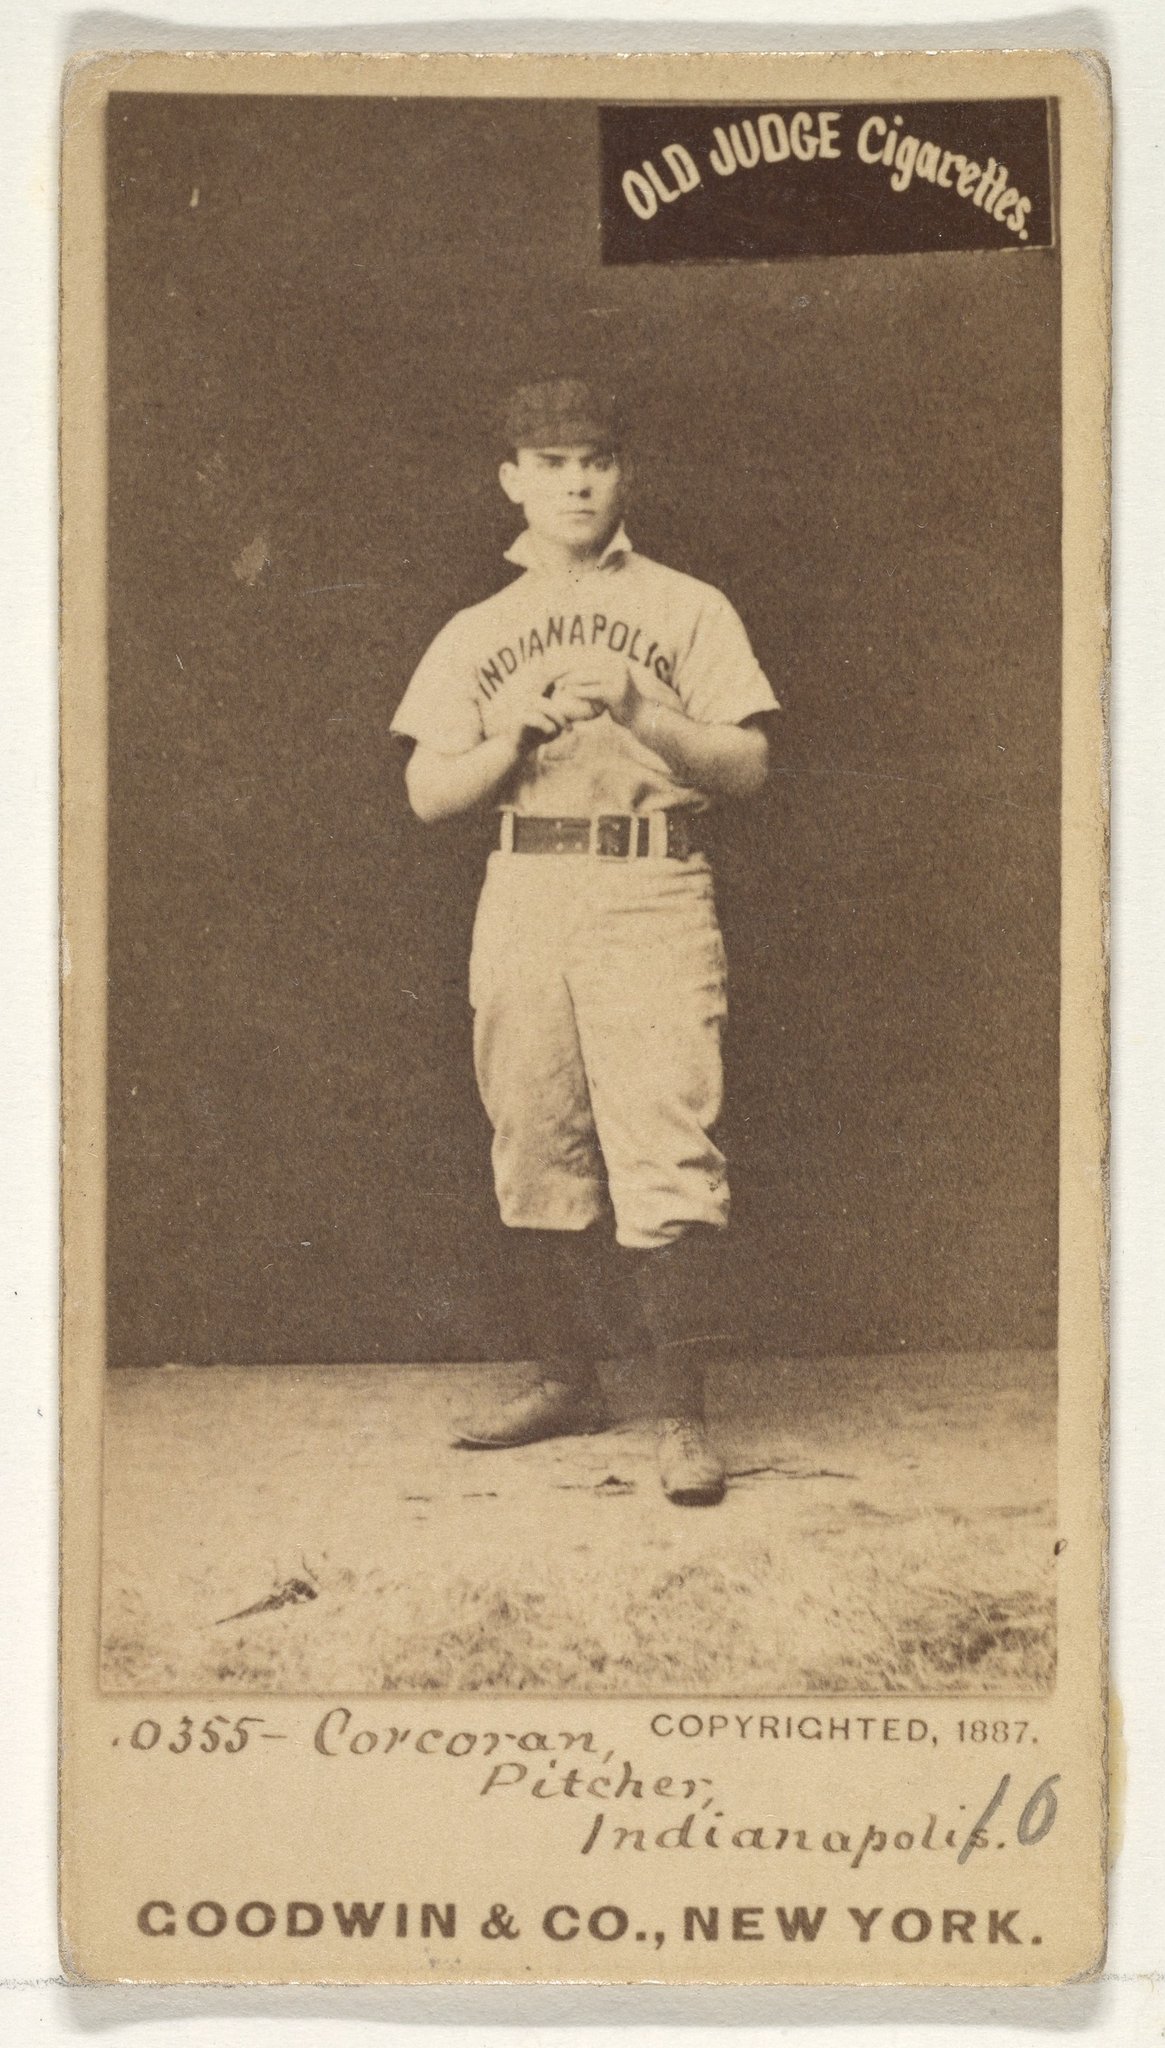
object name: baseball card, photograph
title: Corcoran, Pitcher, Indianapolis, from the Old Judge series (N172) for Old Judge Cigarettes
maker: goodwin & company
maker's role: publisher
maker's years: 1850-1950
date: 1887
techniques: albumen silver print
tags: men,portraits,baseball,athletes